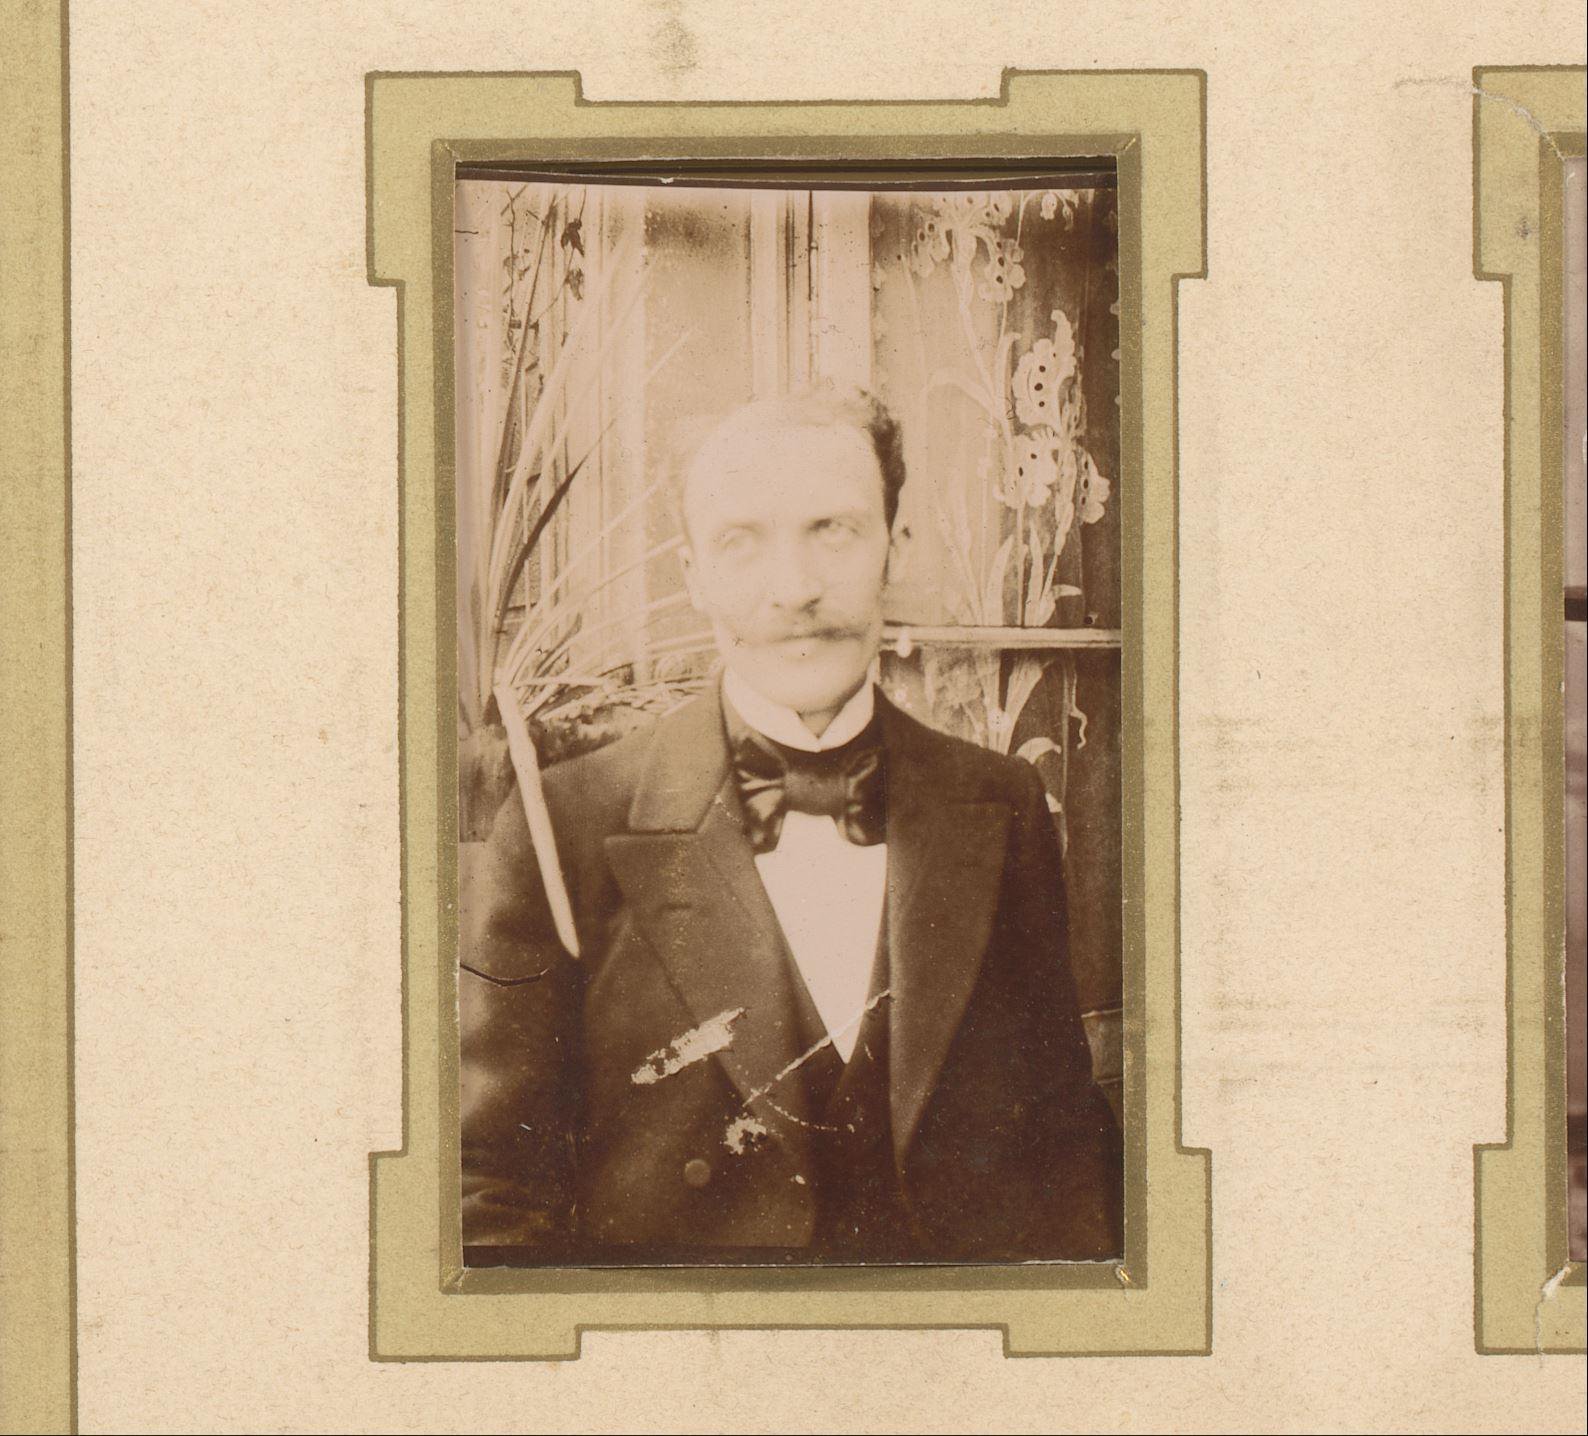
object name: album leaf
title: Portret van een man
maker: Anonymous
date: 1890-1920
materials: cardboard, photographic support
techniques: gelatin silver print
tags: historical persons